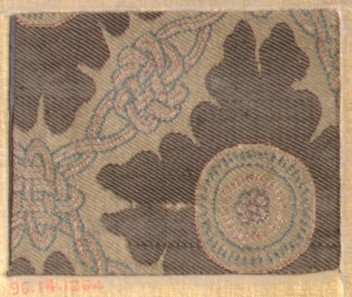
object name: piece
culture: japanese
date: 1701-1900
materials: silk